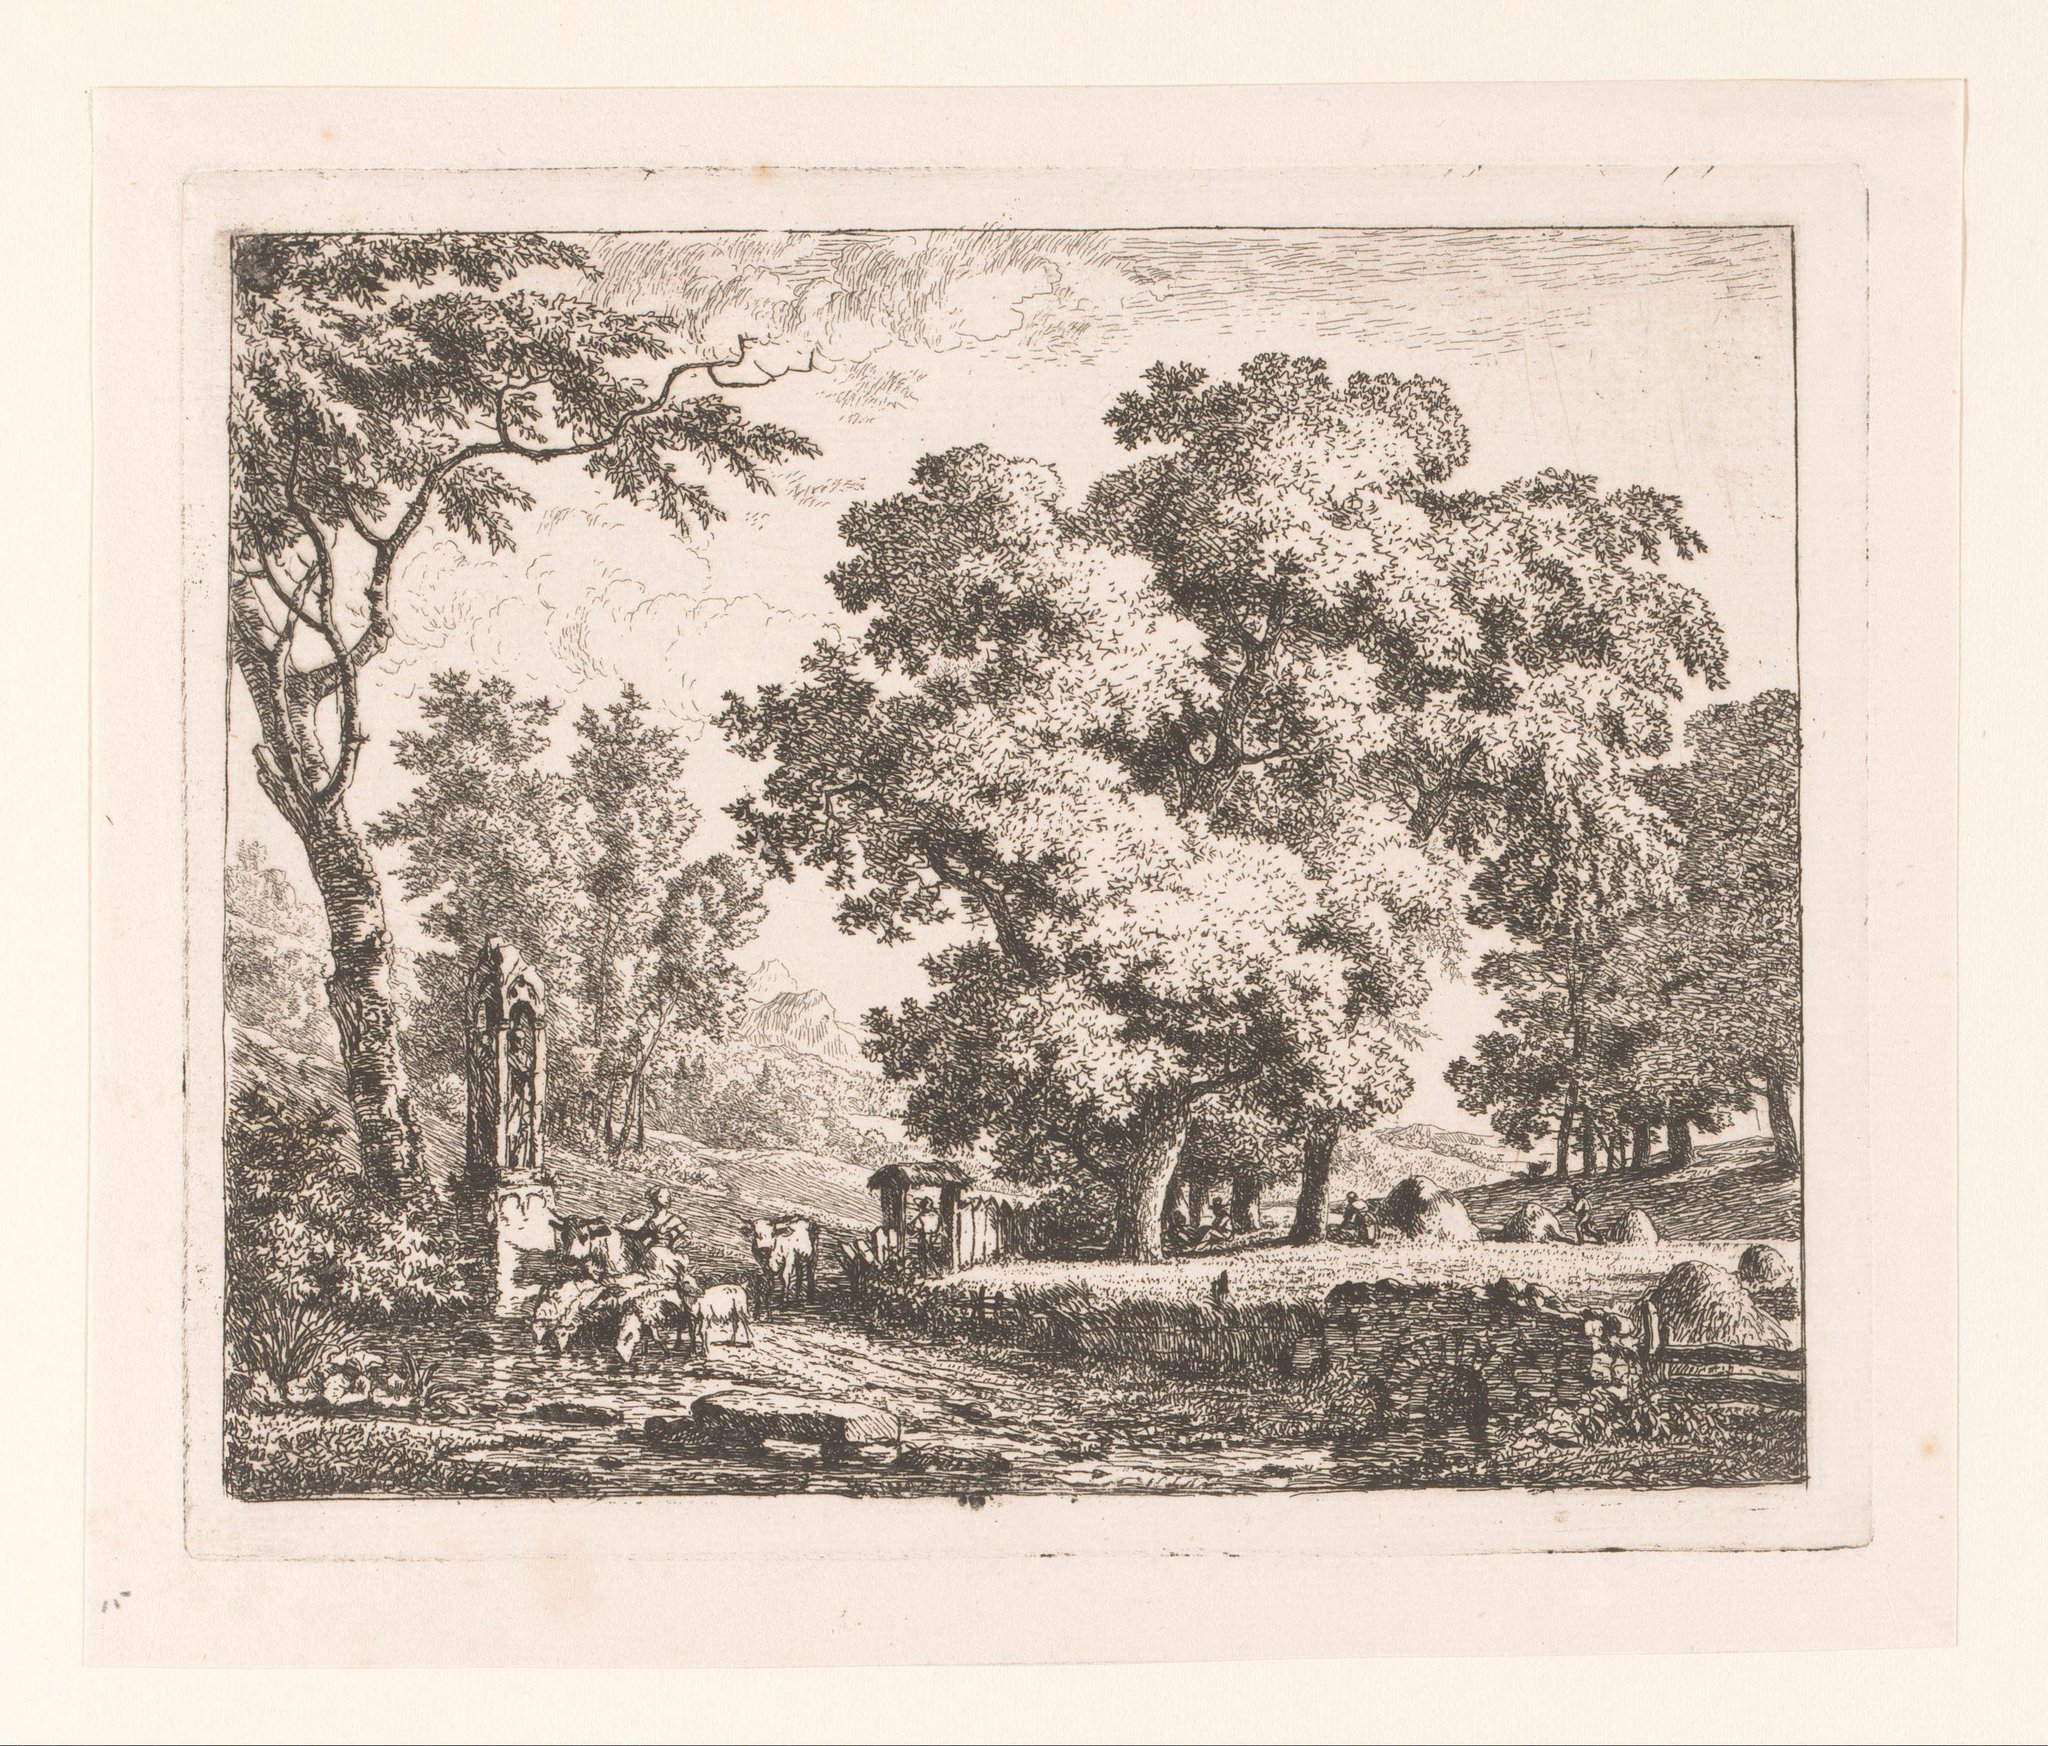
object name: print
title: Landschap met vee dat water drinkt bij een kapel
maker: jean louis demarne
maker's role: draughtsman, painter, print maker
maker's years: 1752-1829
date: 1762-1829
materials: paper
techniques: etching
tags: herding, herdsman, herdswoman, shepherd, shepherdess, cowherd, etc., landscape with ruins, landscapes with waters, waterscapes, seascapes (in the temperate zone) (+ landscape with figures, staffage)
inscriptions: collector's mark: Lugt 2228